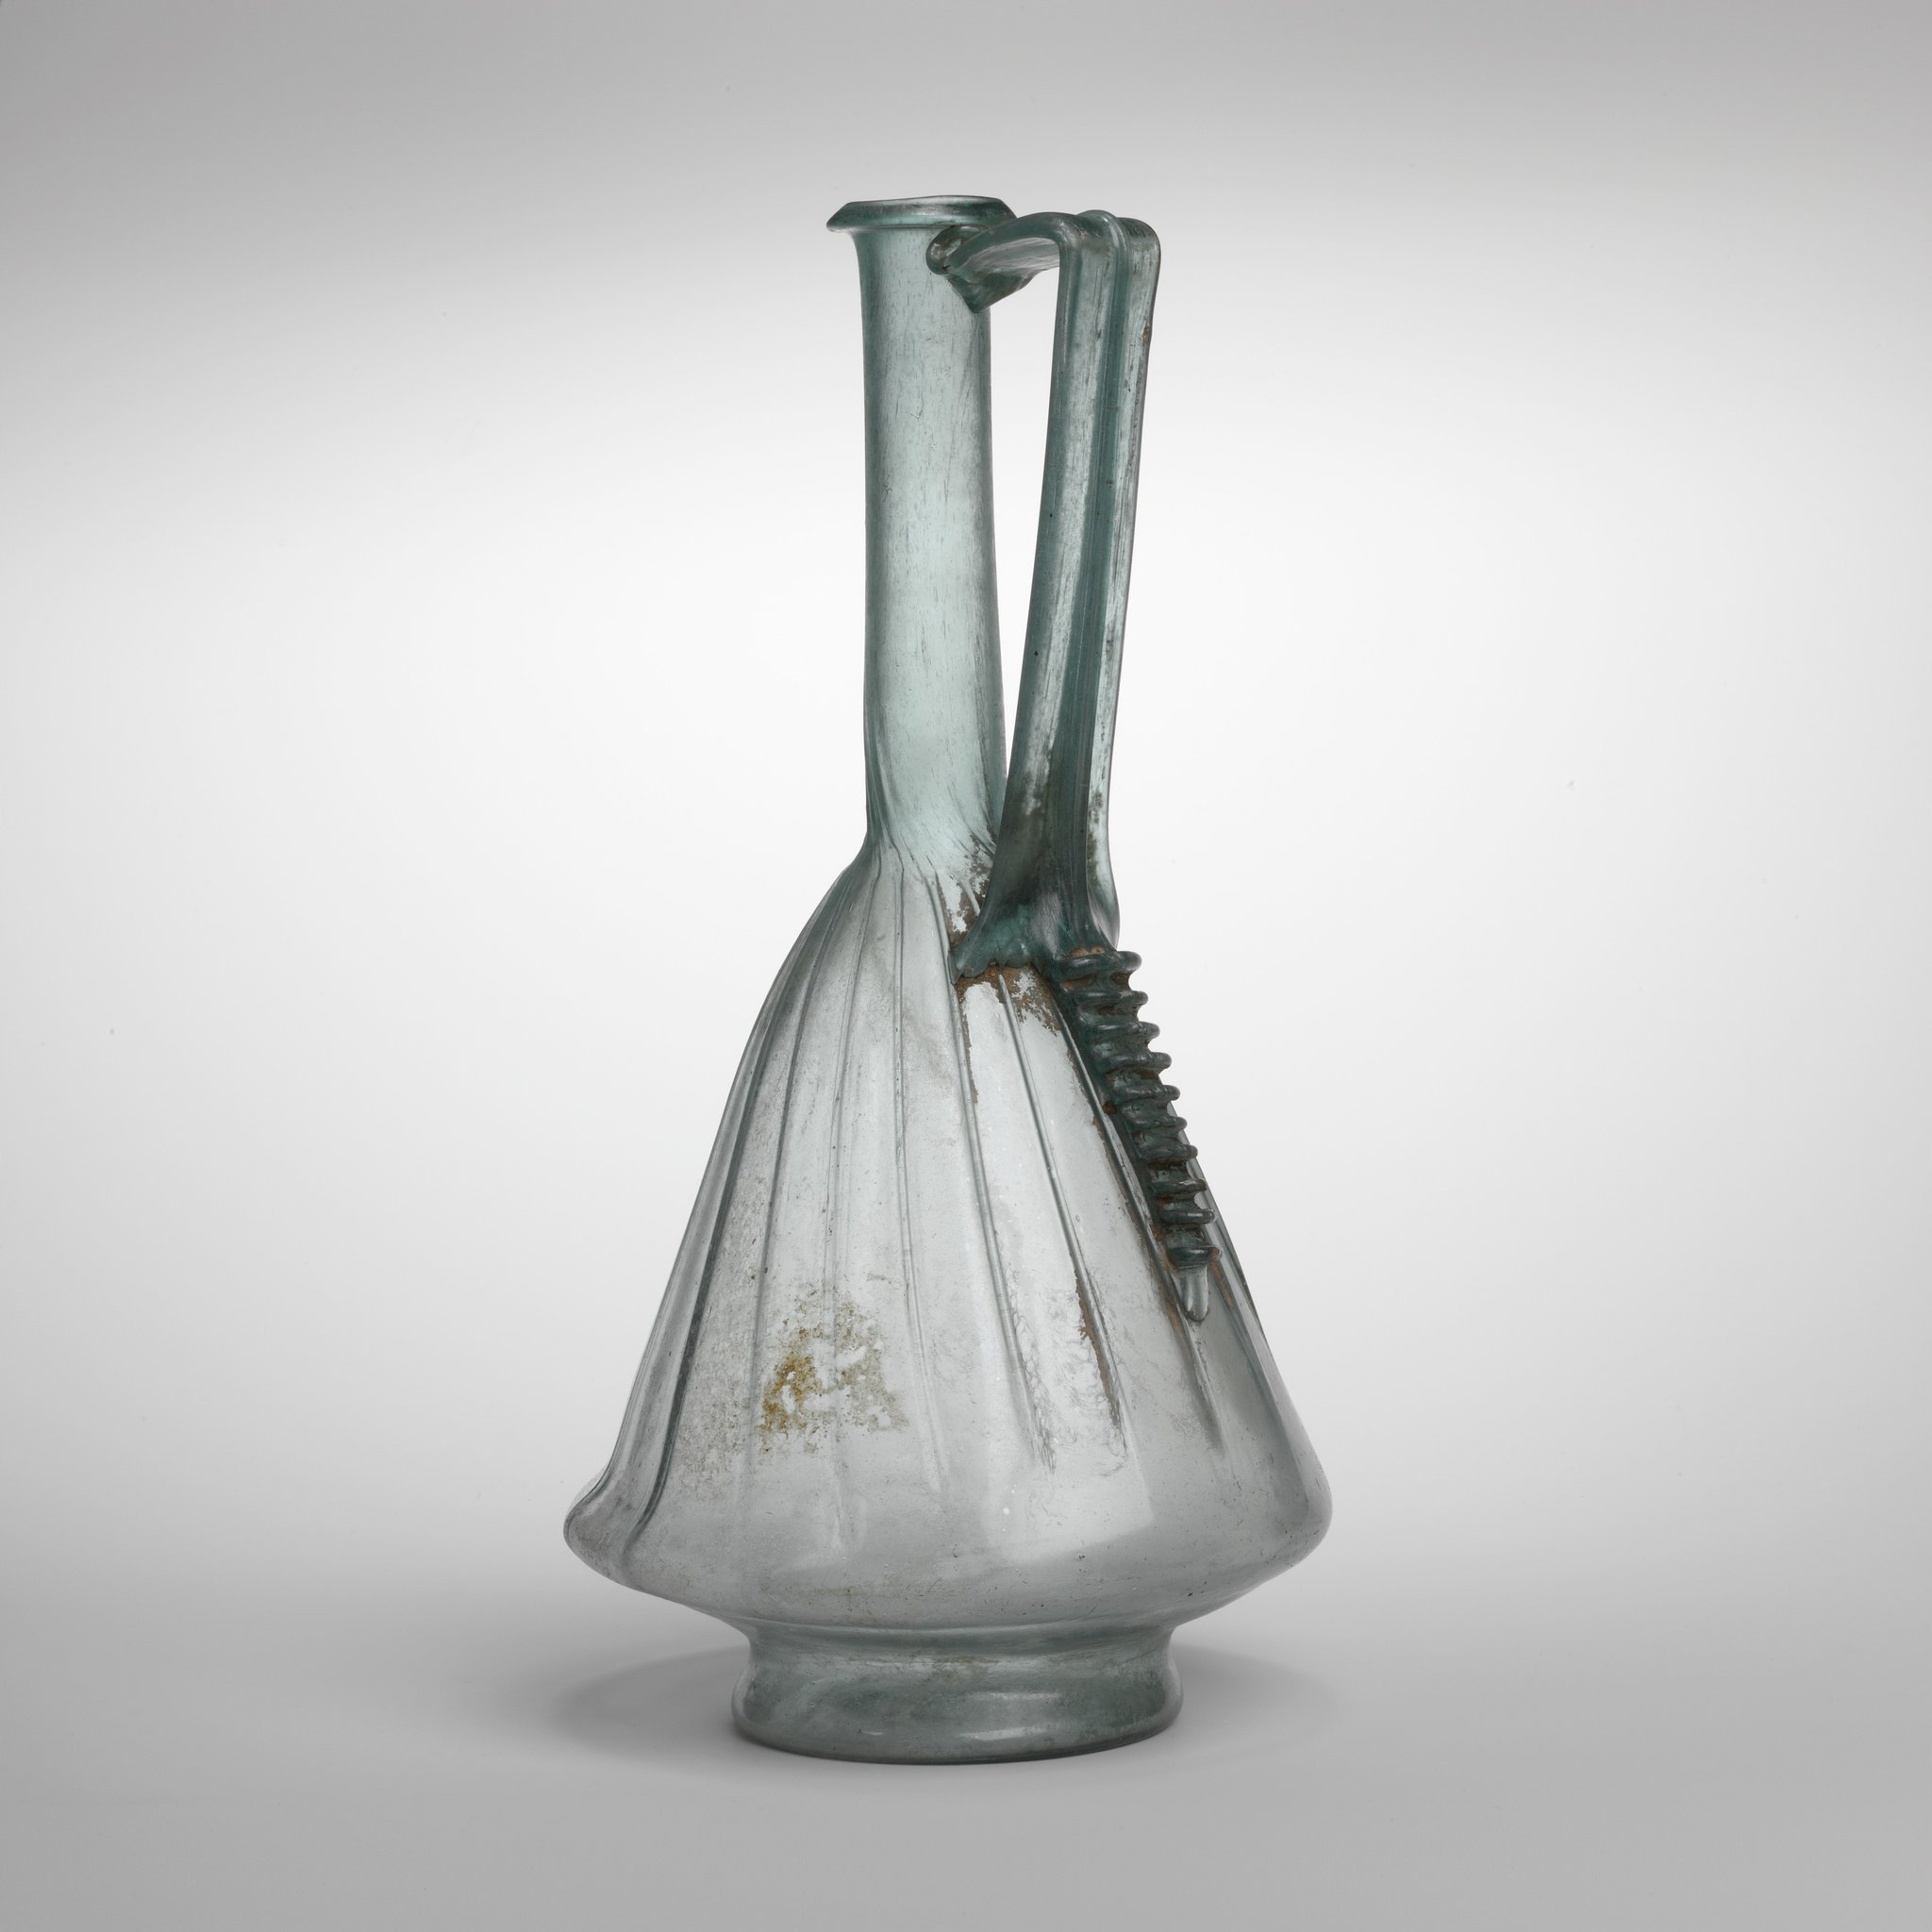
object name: jug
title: Glass jug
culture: roman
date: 34-133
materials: glass